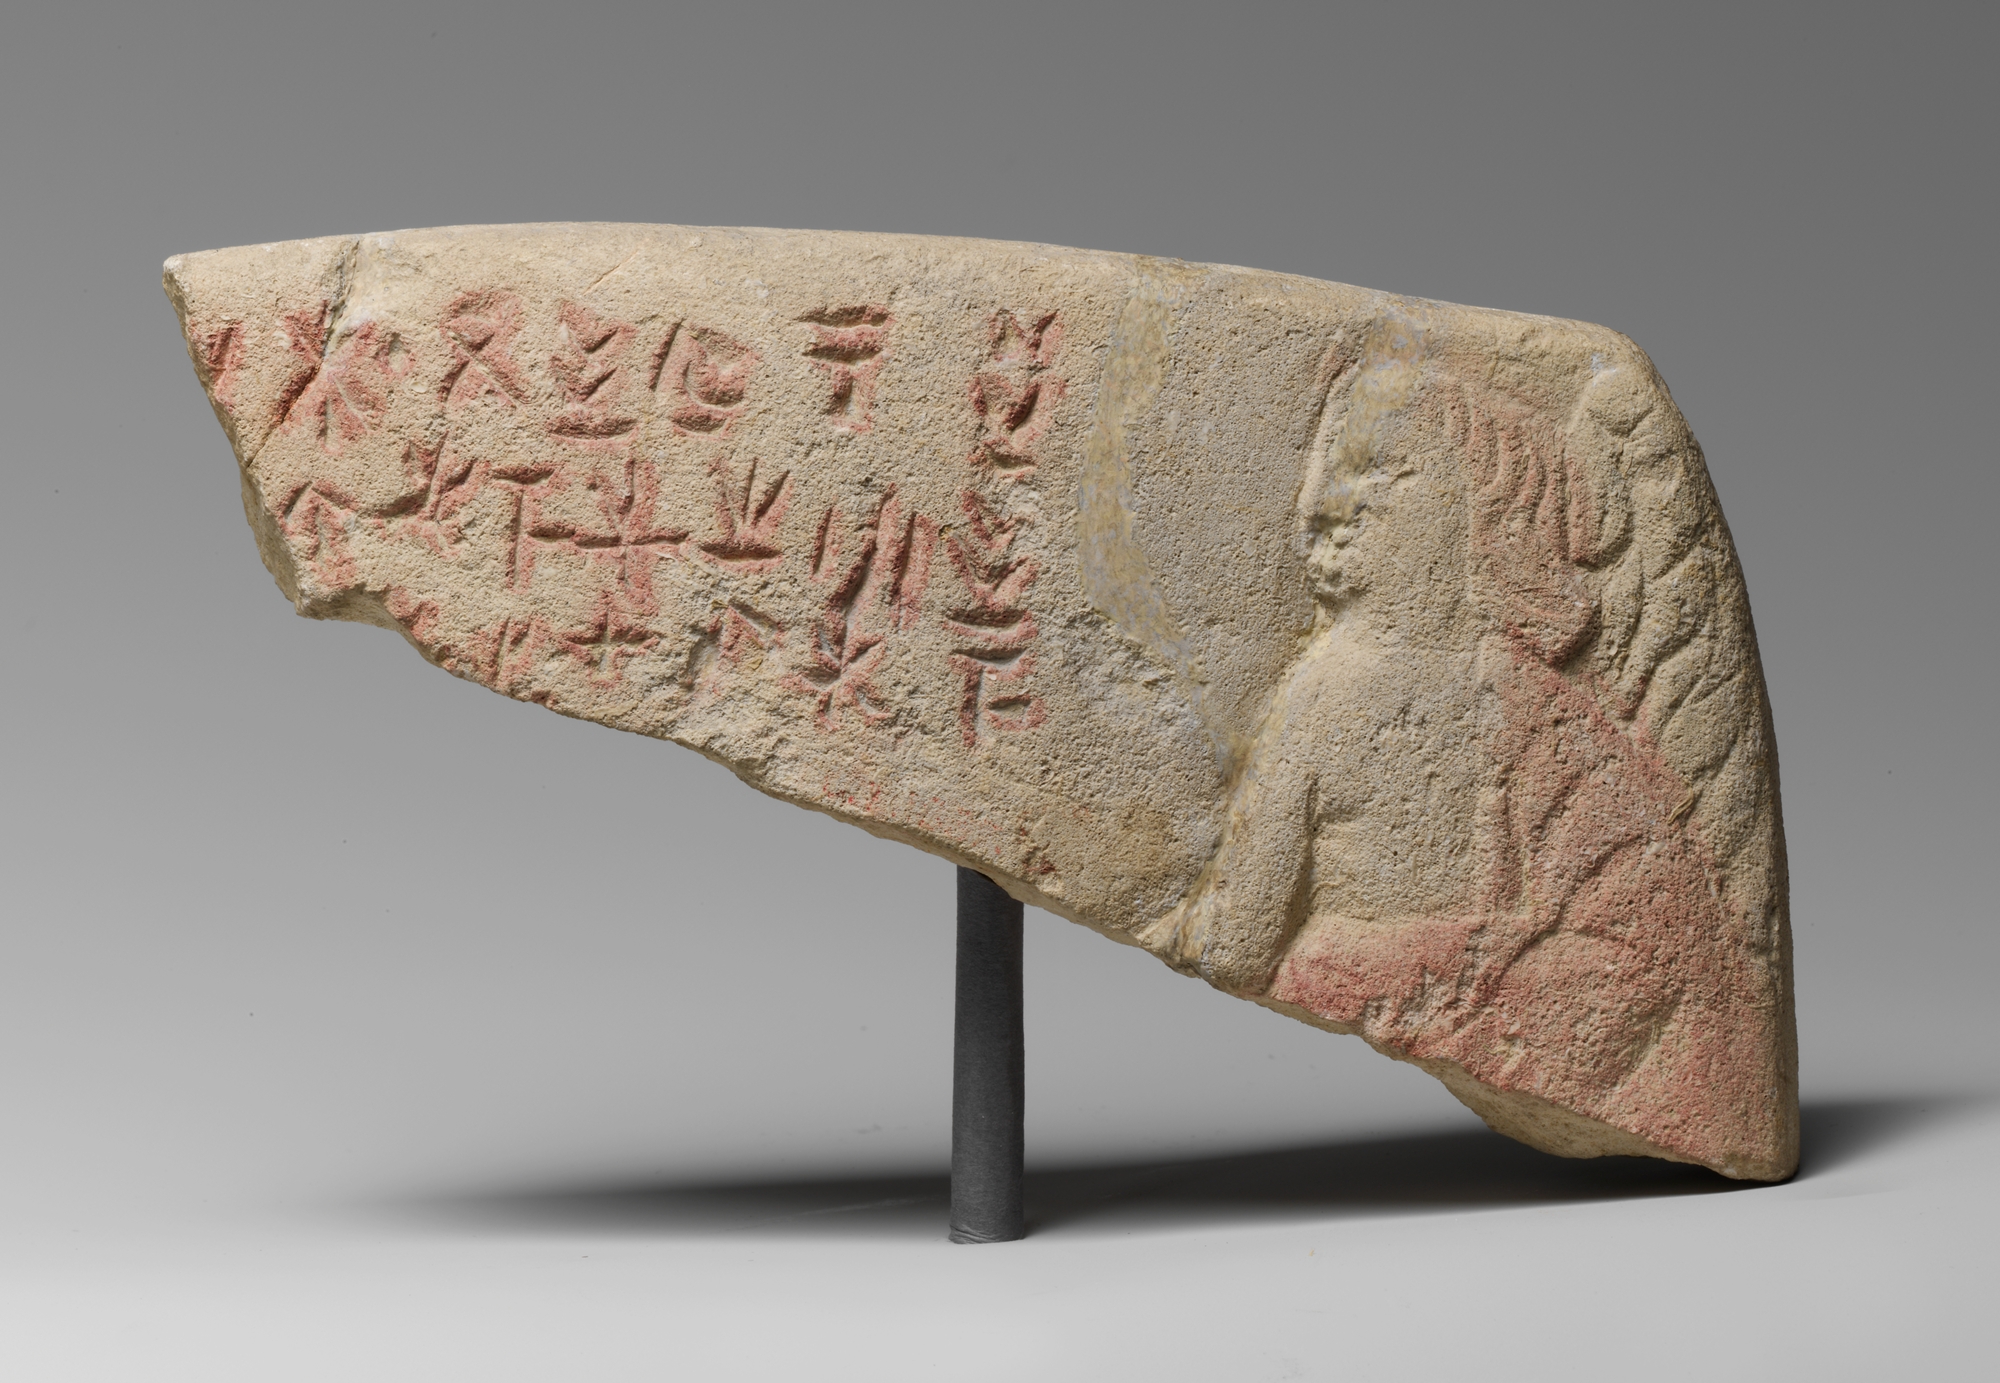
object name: votive relief fragment of a seated deity with an inscribed dedication to apollo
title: Limestone votive relief fragment of a seated deity with an inscribed dedication to Apollo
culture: cypriot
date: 300-201 BCE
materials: limestone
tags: apollo